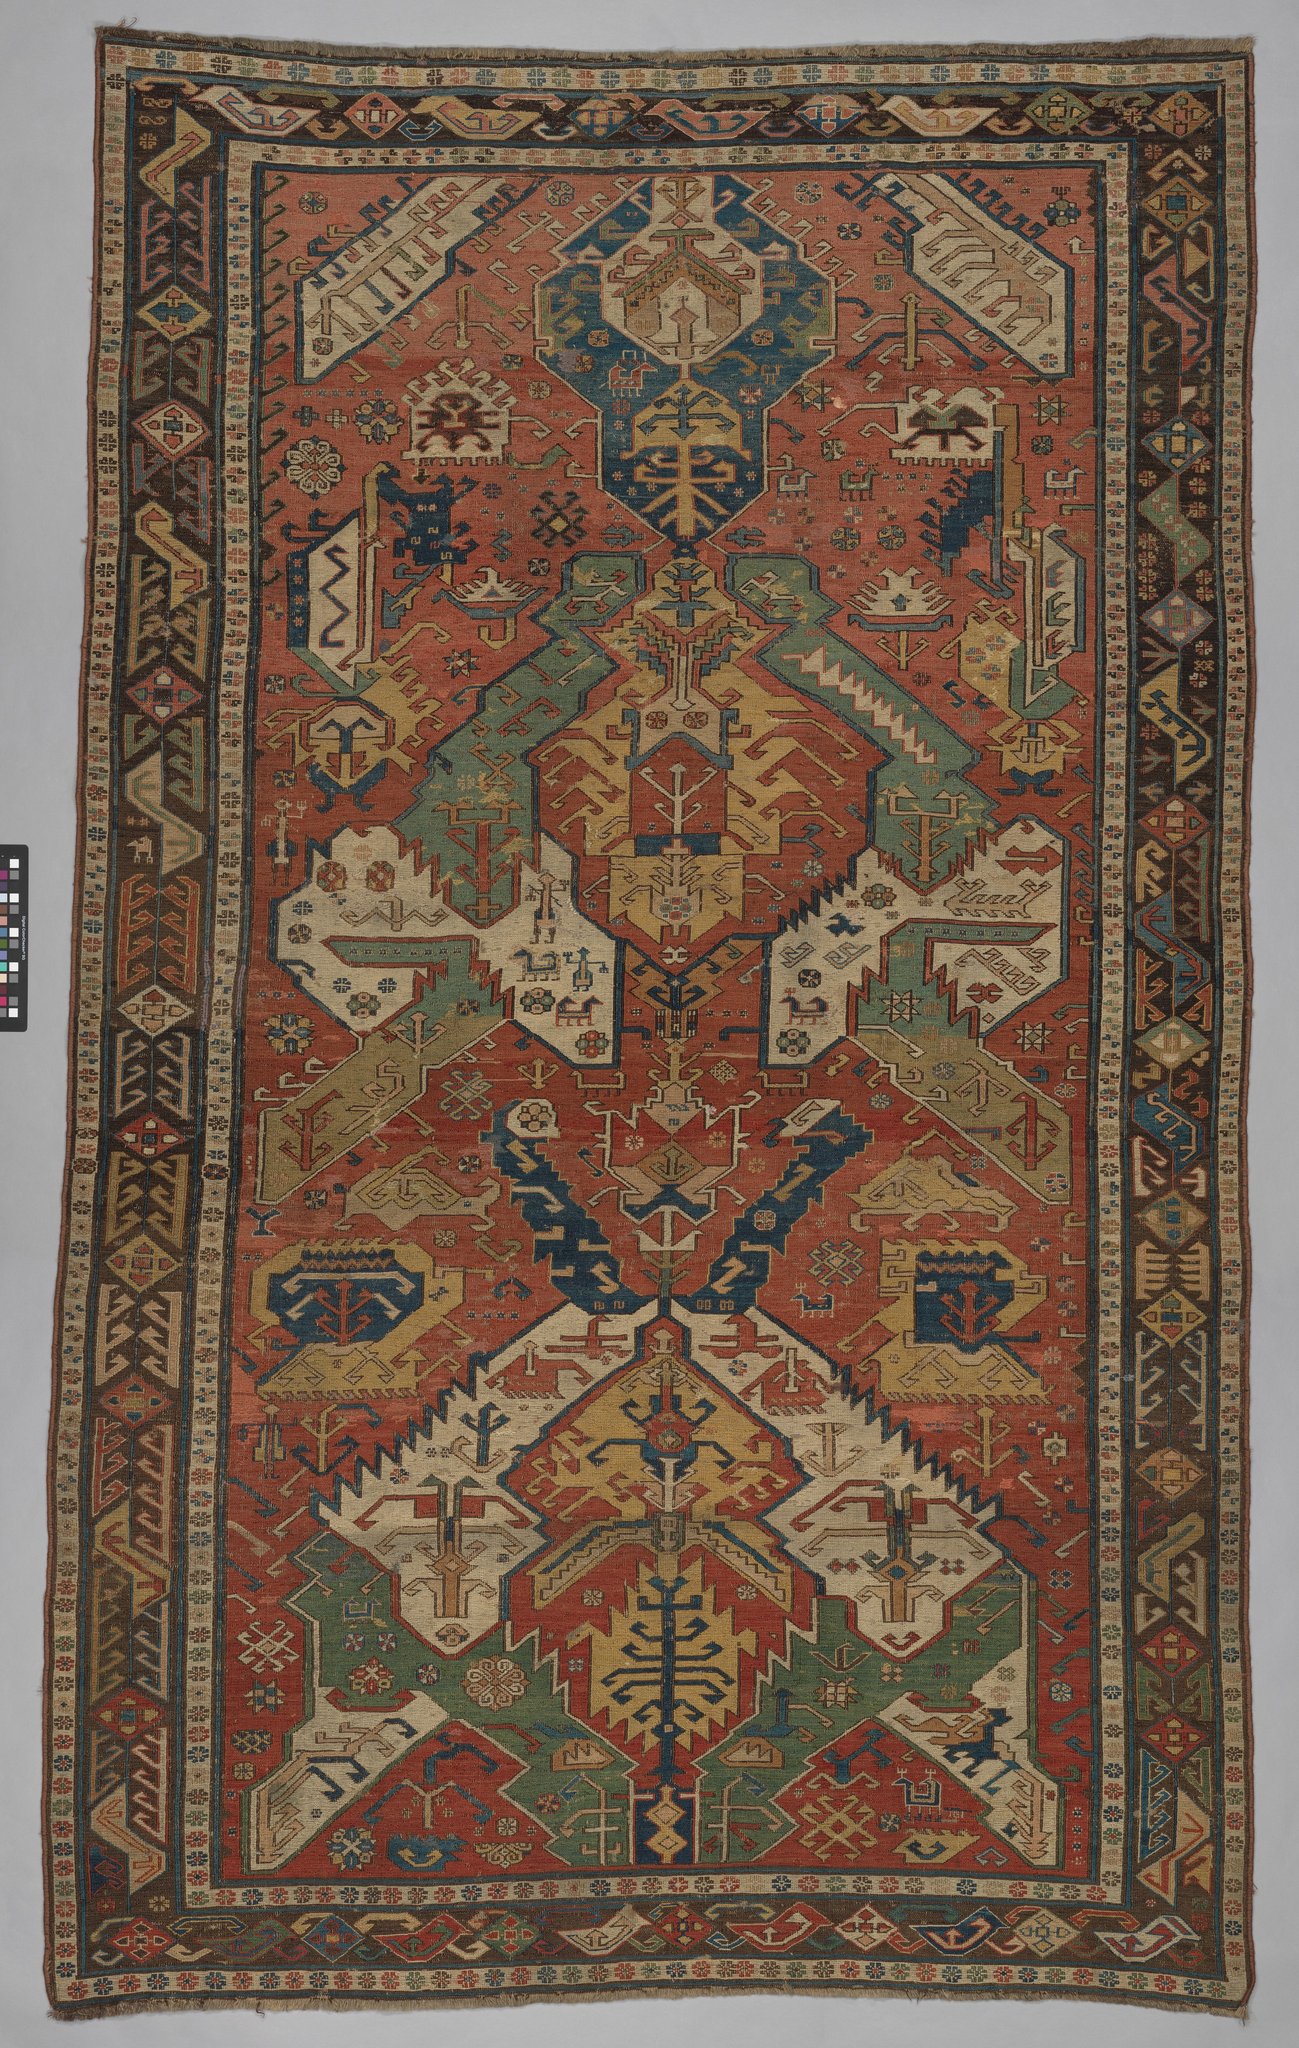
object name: carpet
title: Carpet with a Geometricized Medallion Design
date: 1867-1900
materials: wool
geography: azerbaijan